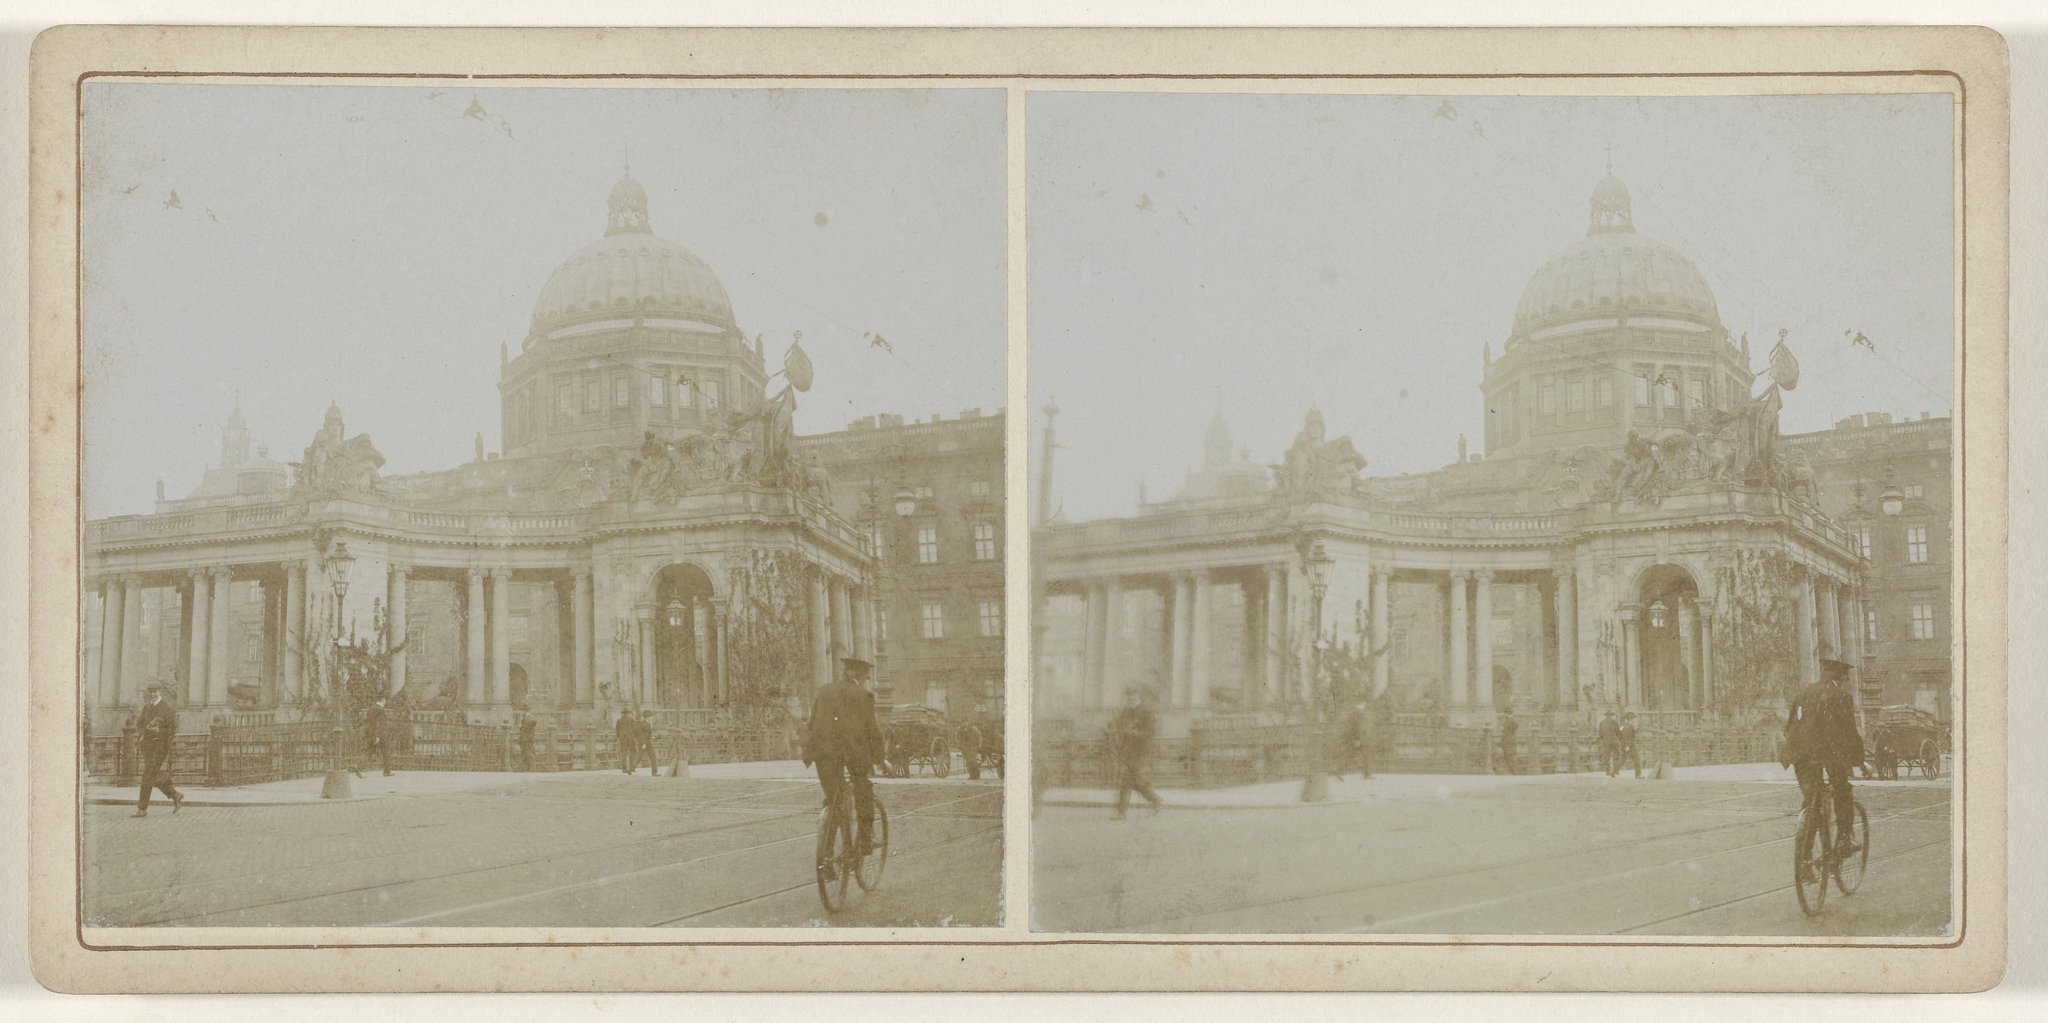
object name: stereograph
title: Het keizerlijk slot te Berlijn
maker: geldolph adriaan kessler (dolph)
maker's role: fotograaf, industrieel, voetballer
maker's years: 1884-1945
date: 1903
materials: paper, photographic support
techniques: collodion silver print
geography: netherlands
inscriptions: title: ‘Het keizerlijk slot te Berlijn’